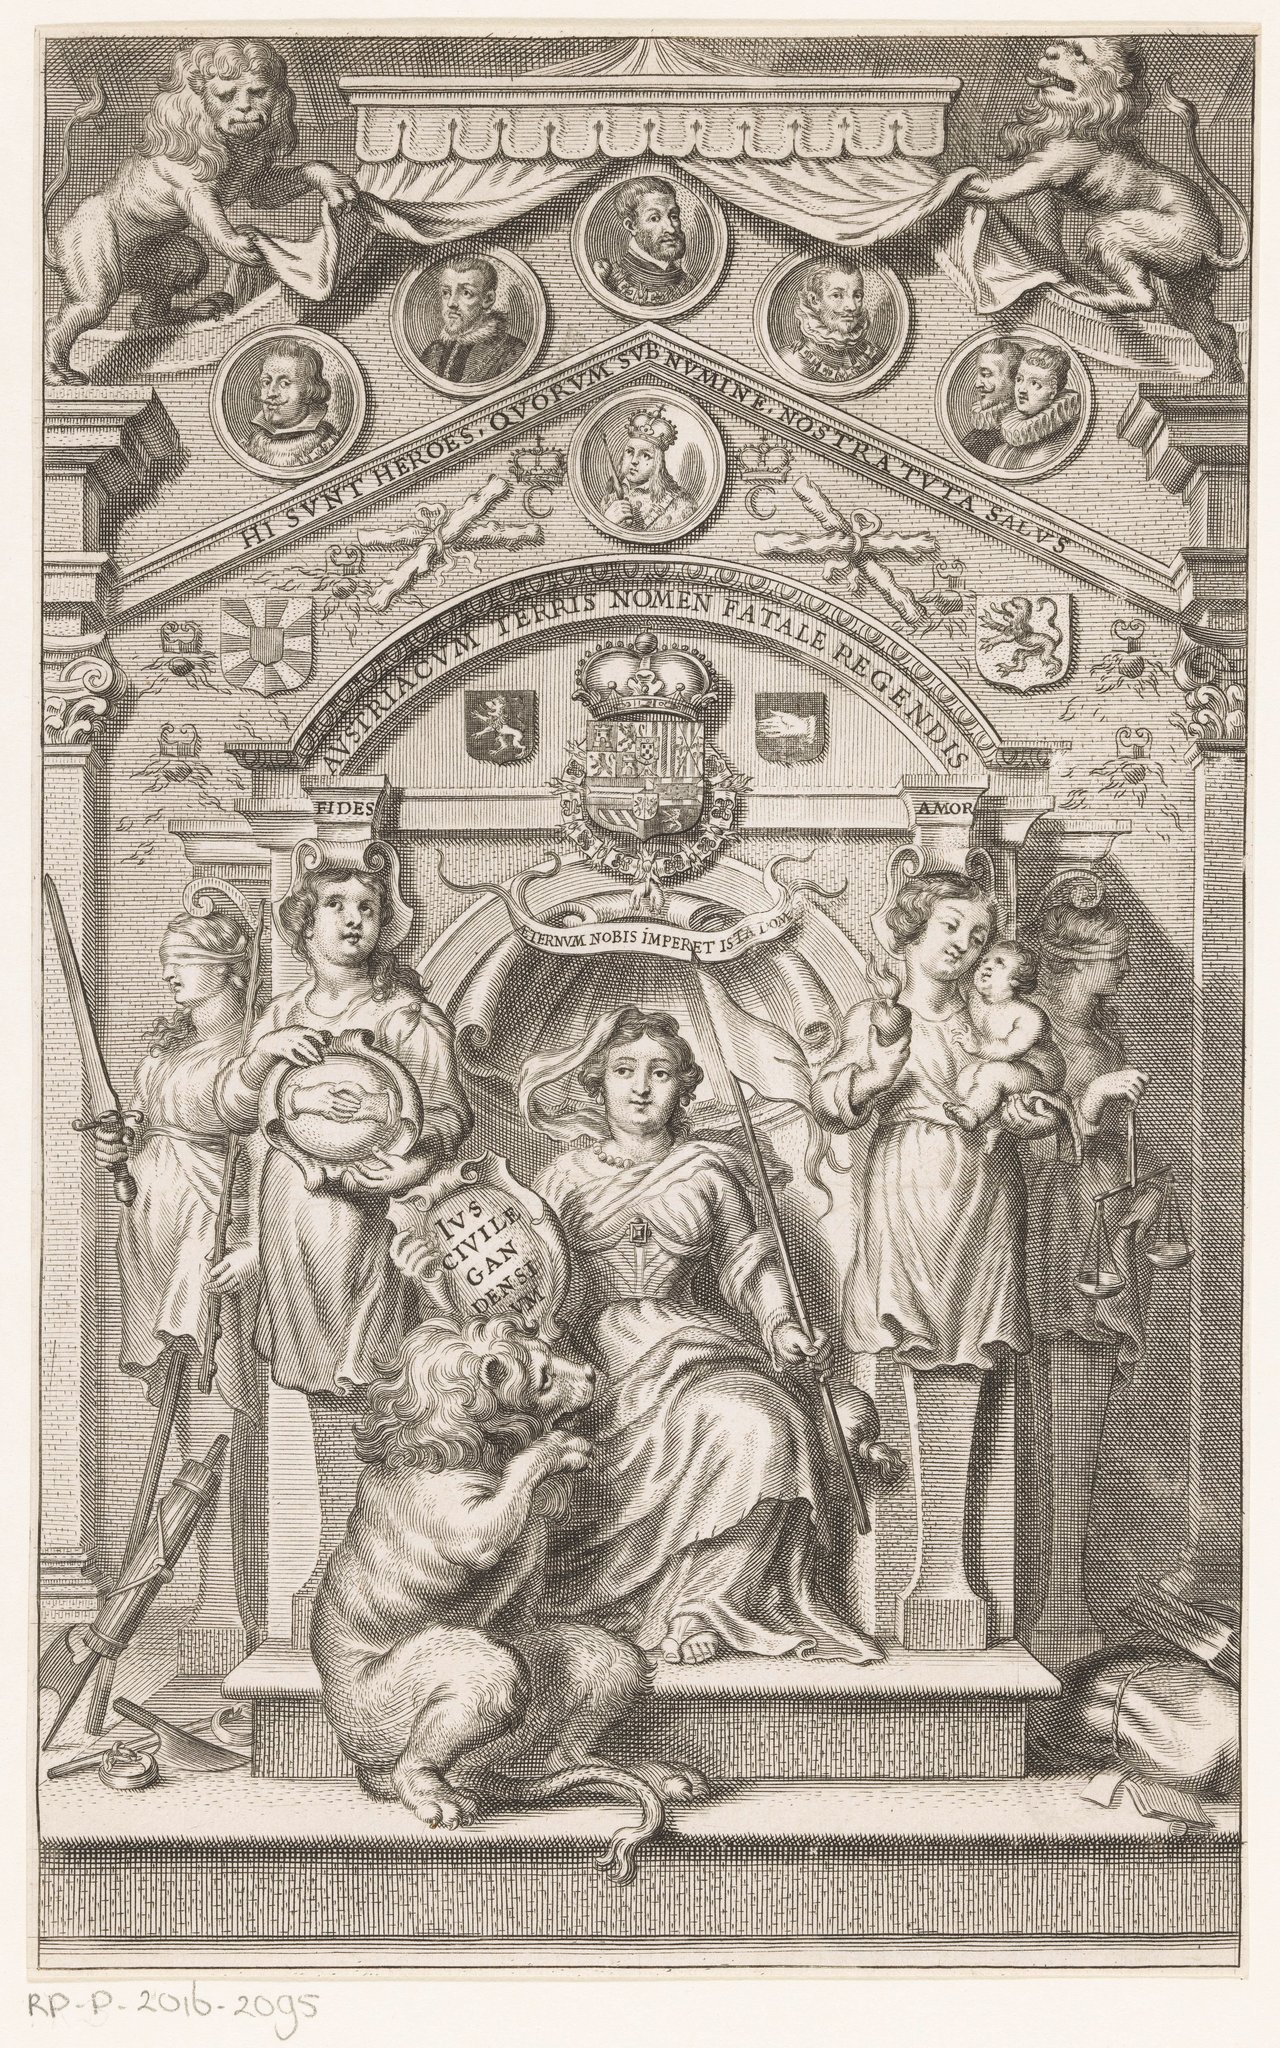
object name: titelblad, titelpagina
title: Titelpagina voor: Joannes Antonius Cnobbaert, Jus civile gandensium, 1677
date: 1677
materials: paper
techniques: engraving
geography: antwerp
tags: personifications of countries, nations, states, districts, etc., pedestal of a piece of sculpture (perhaps in the form of a herm), ghent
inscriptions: collector's mark: Lugt 240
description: De stedenmaagd van Gent zit getroond met een banier en een cartouche met titel in de hand. Bij haar voeten ligt de Gentse leeuw. De stedenmaagd wordt geflankeerd door vier vrouwelijke termen; uiterst links en rechts staan twee vrouwen zijn geblinddoekt en dragen een zwaard en weegschaal in de hand (mogelijk personifiëren zij Rechtvaardigheid), linksvoor staat een vrouw met cartouche met elkaar schuddende handen, rechtsvoor een vrouw met brandend hart en kind op de arm (mogelijk (Naasten)Liefde). Boven de troon een gekroond wapenschild en zes portretmedaillons van heersers.